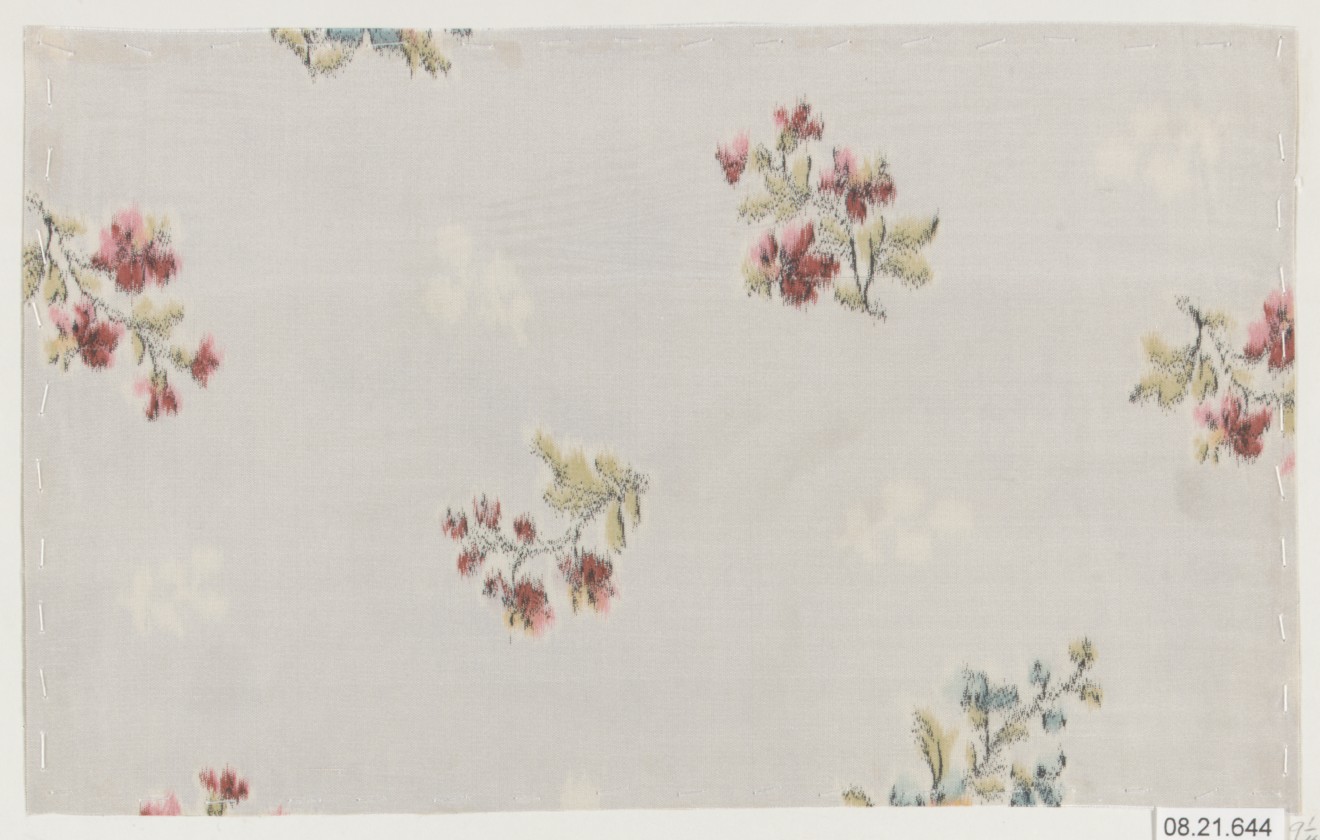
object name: textile sample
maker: Anonymous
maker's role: designer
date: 1900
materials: silk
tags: flowers